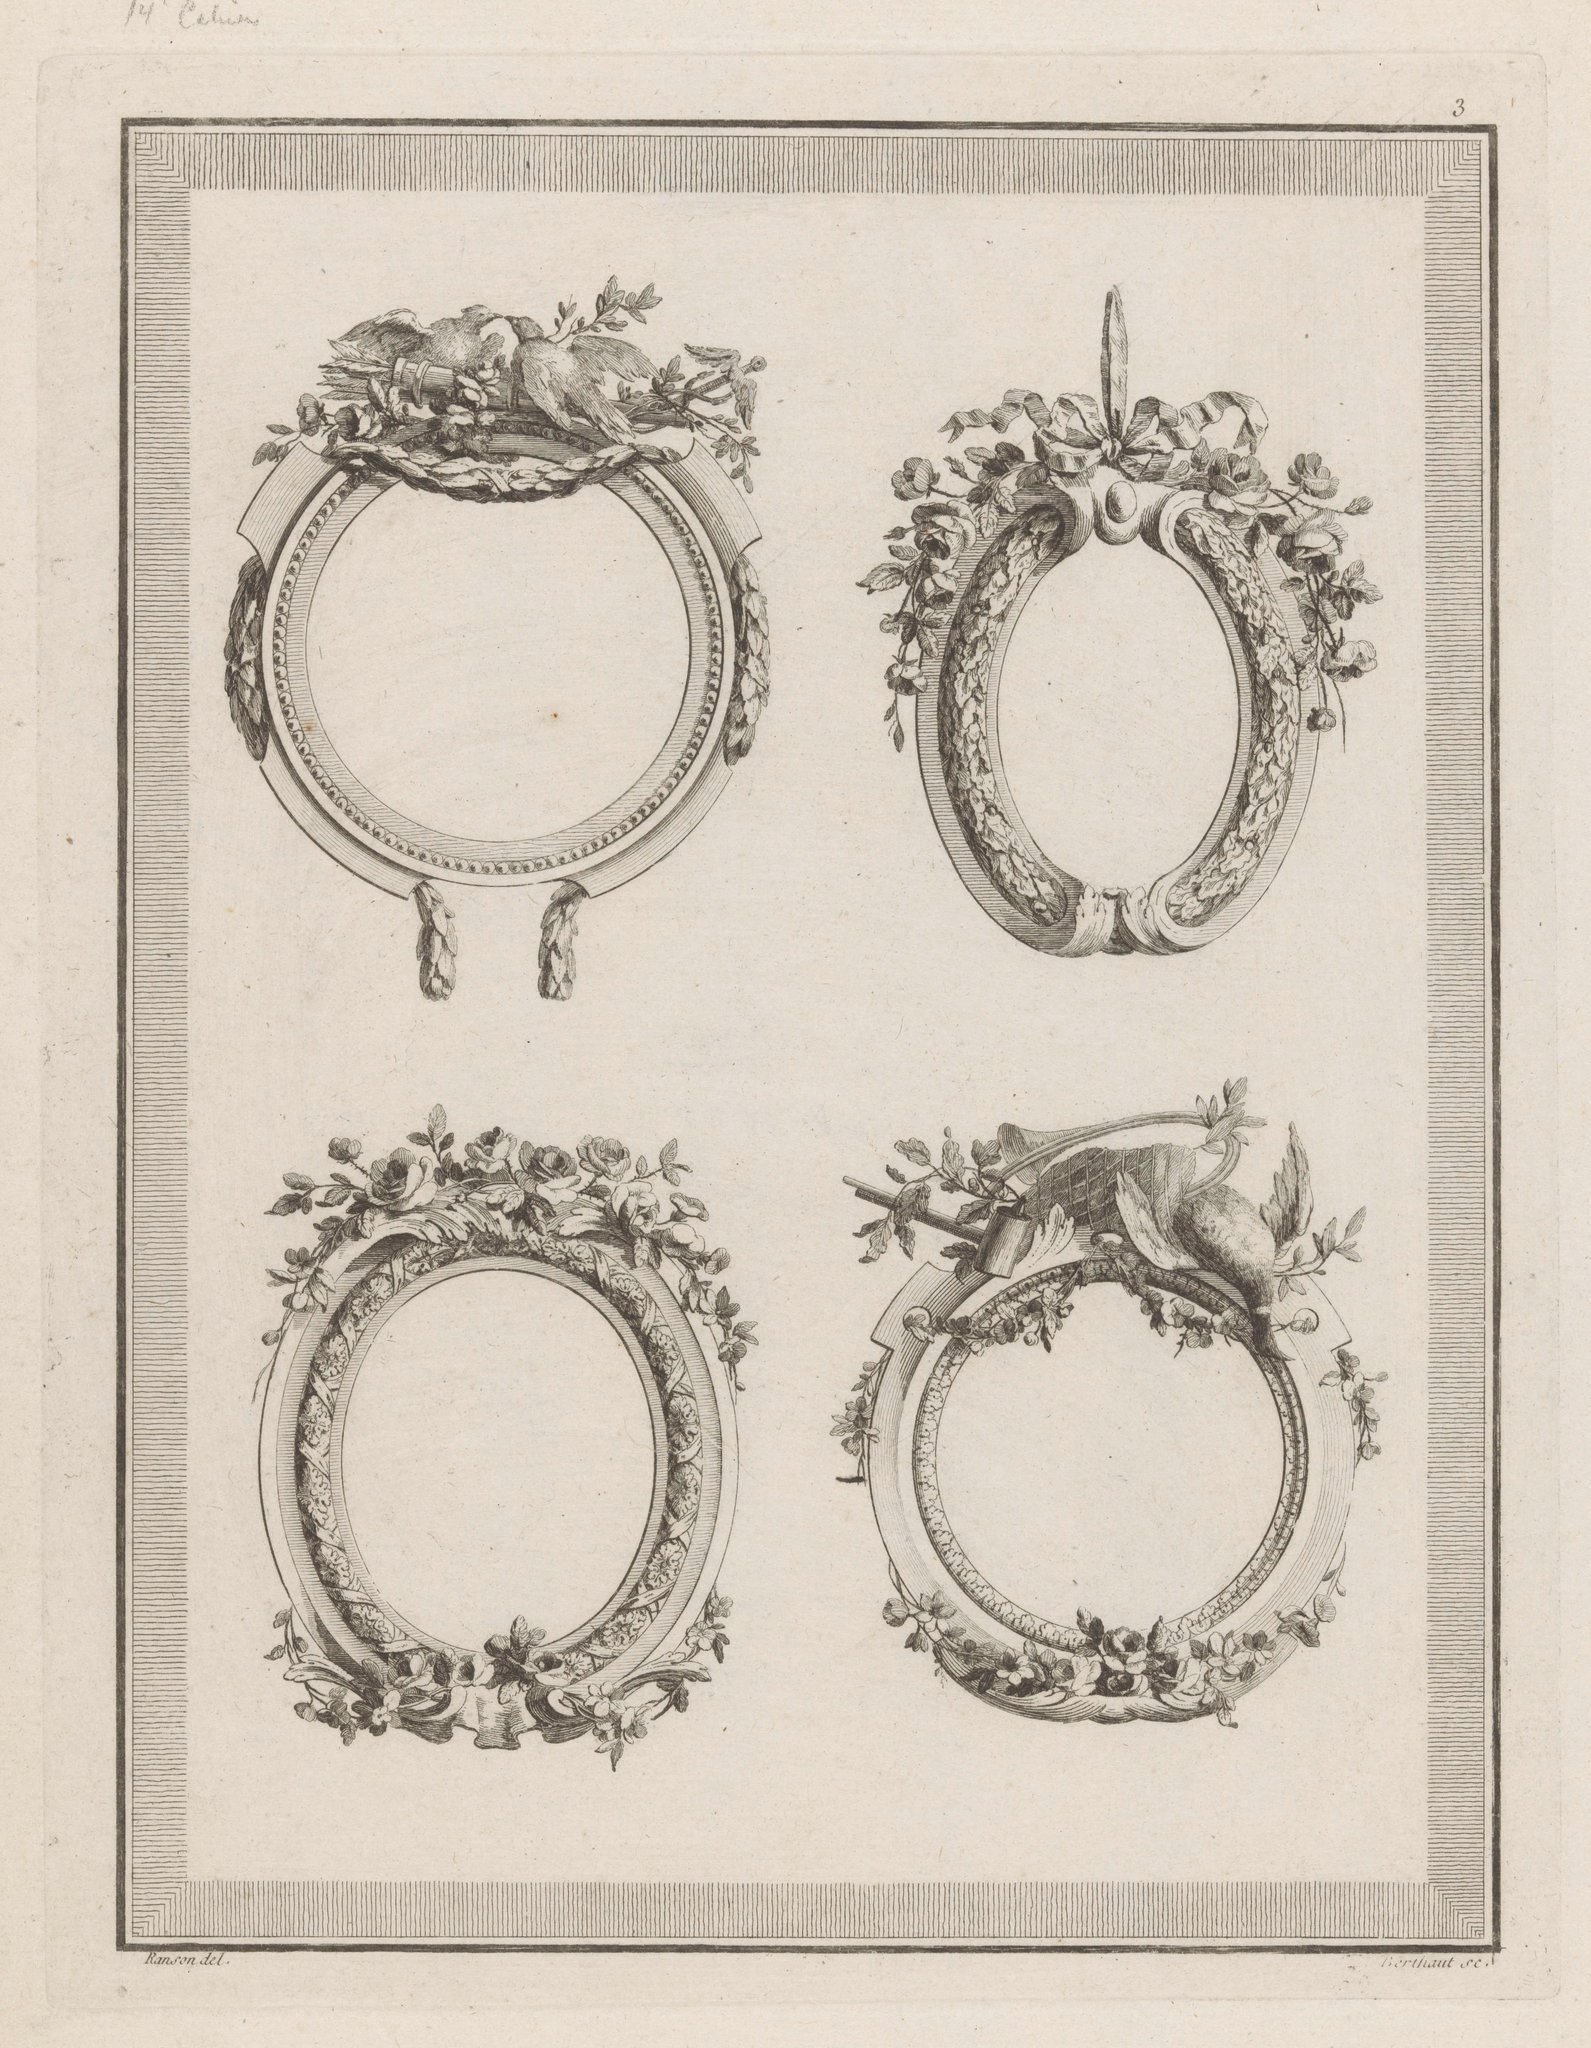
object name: ornament print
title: 14e Cahier de Trophées de l'Oeuvre de Ranson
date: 1778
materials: paper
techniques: etching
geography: paris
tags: trophy, i.e.: decorative arrangement of symbolic or typical objects ~ ornament, other birds: dove, hunting, chase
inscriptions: collector's mark: Lugt 2228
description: Vier medaillons. Links boven met twee duiven, een pijlenkoker en een caduceus. Rechts boven en links onder met rozen. Rechts onder met jachtattributen.